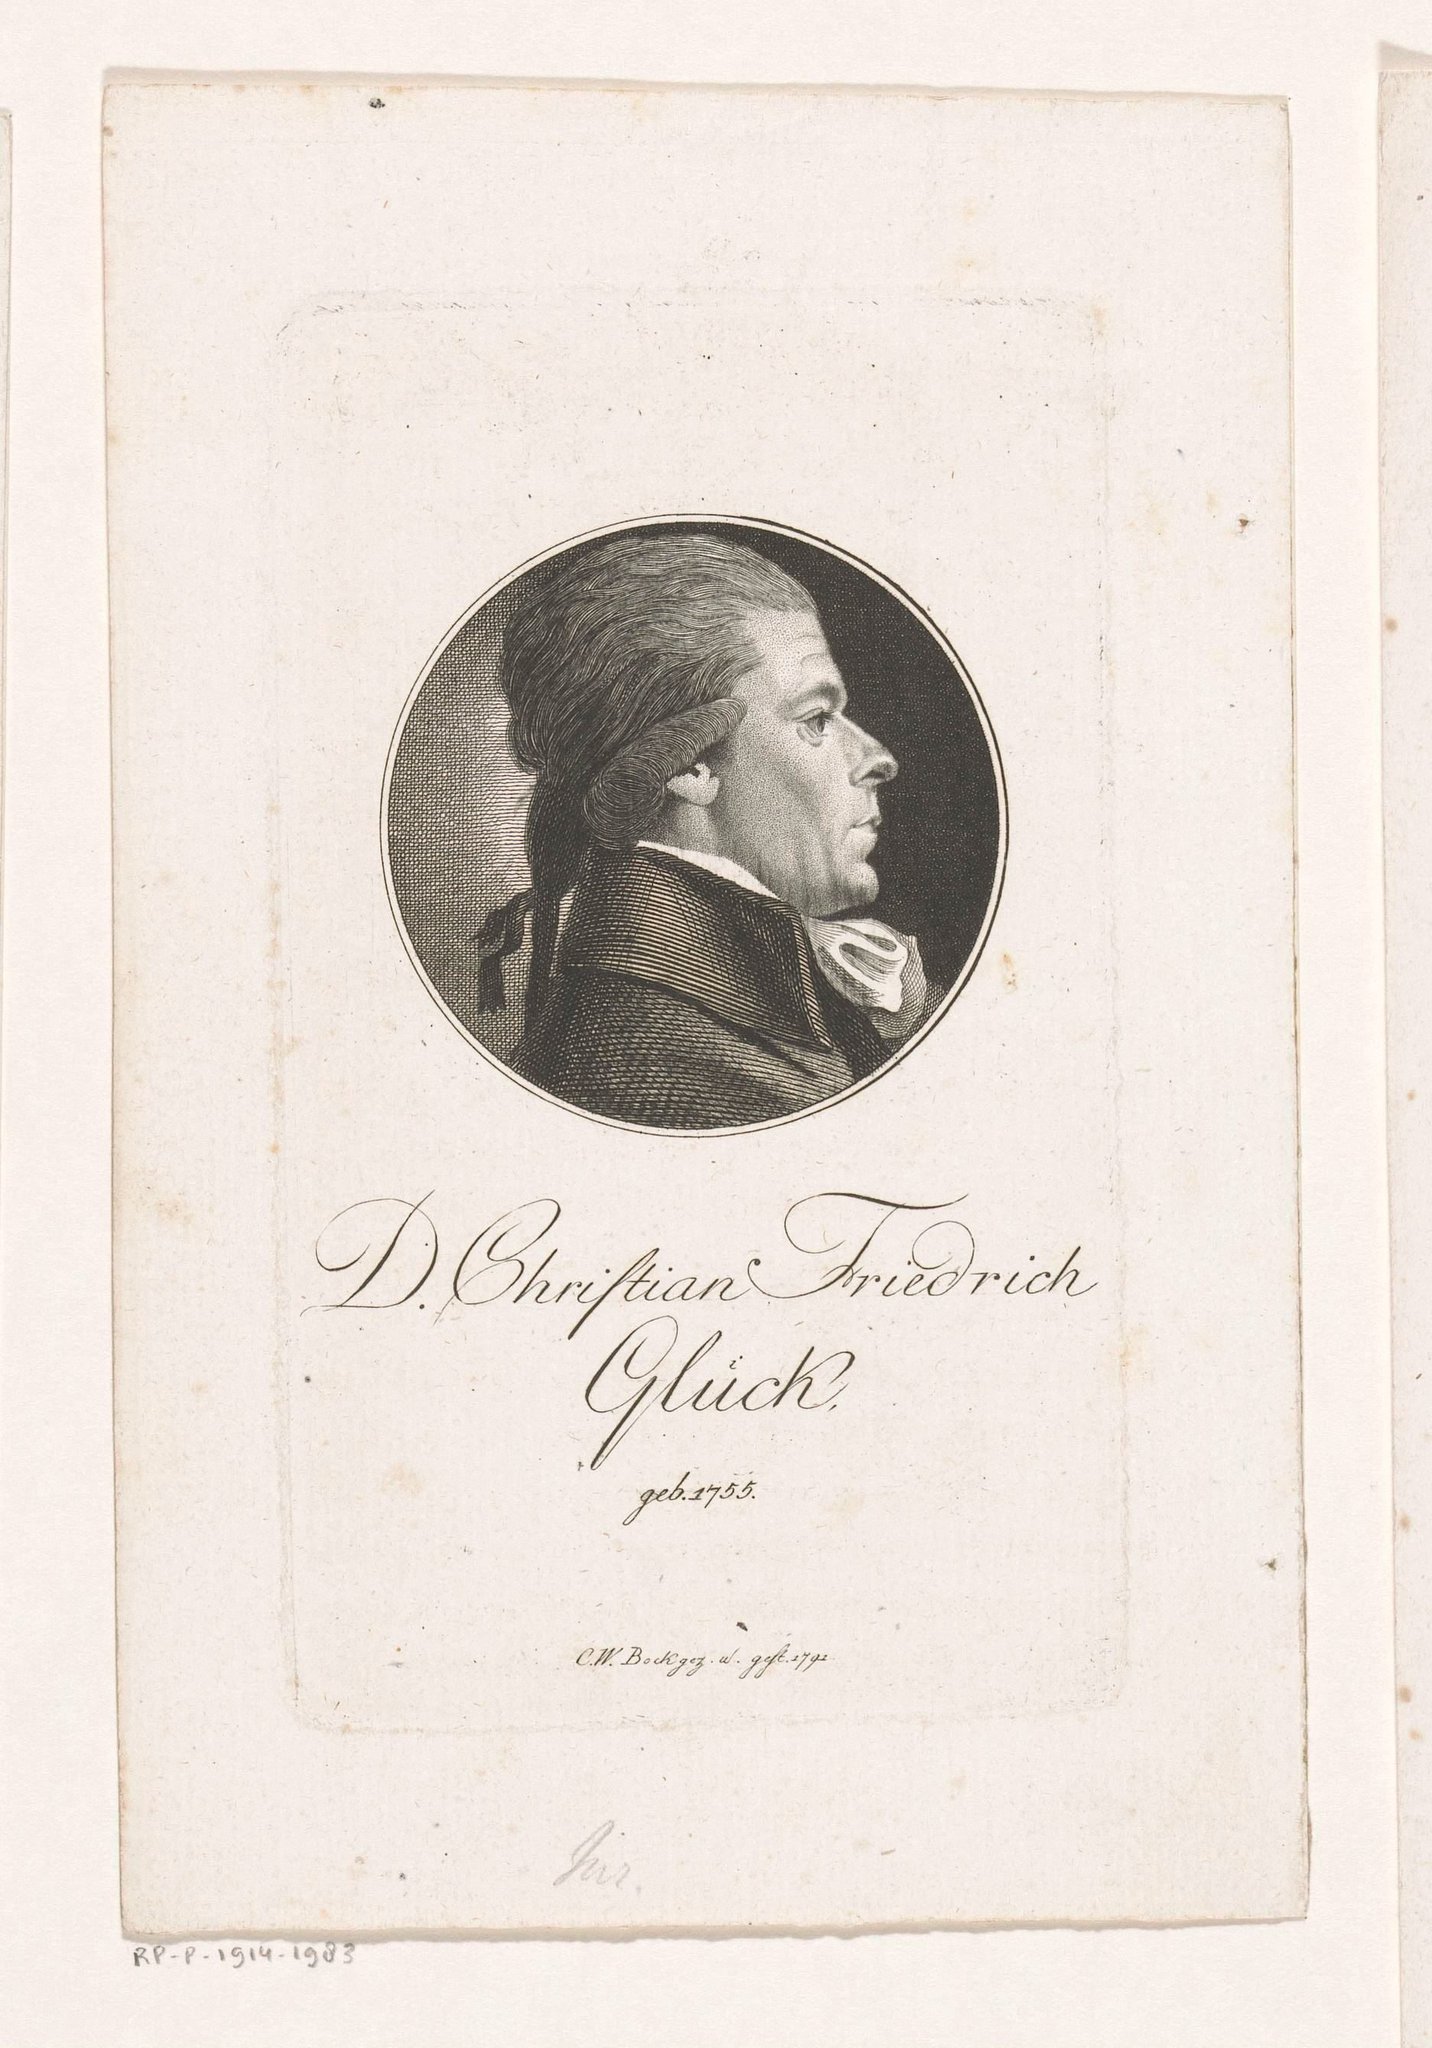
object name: print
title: Portret van Christian Friedrich Glück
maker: christoph wilhelm bock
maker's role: print maker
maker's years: 1755-1836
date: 1791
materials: paper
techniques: engraving, etching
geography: nuremberg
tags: historical persons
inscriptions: collector's mark: Lugt 2228